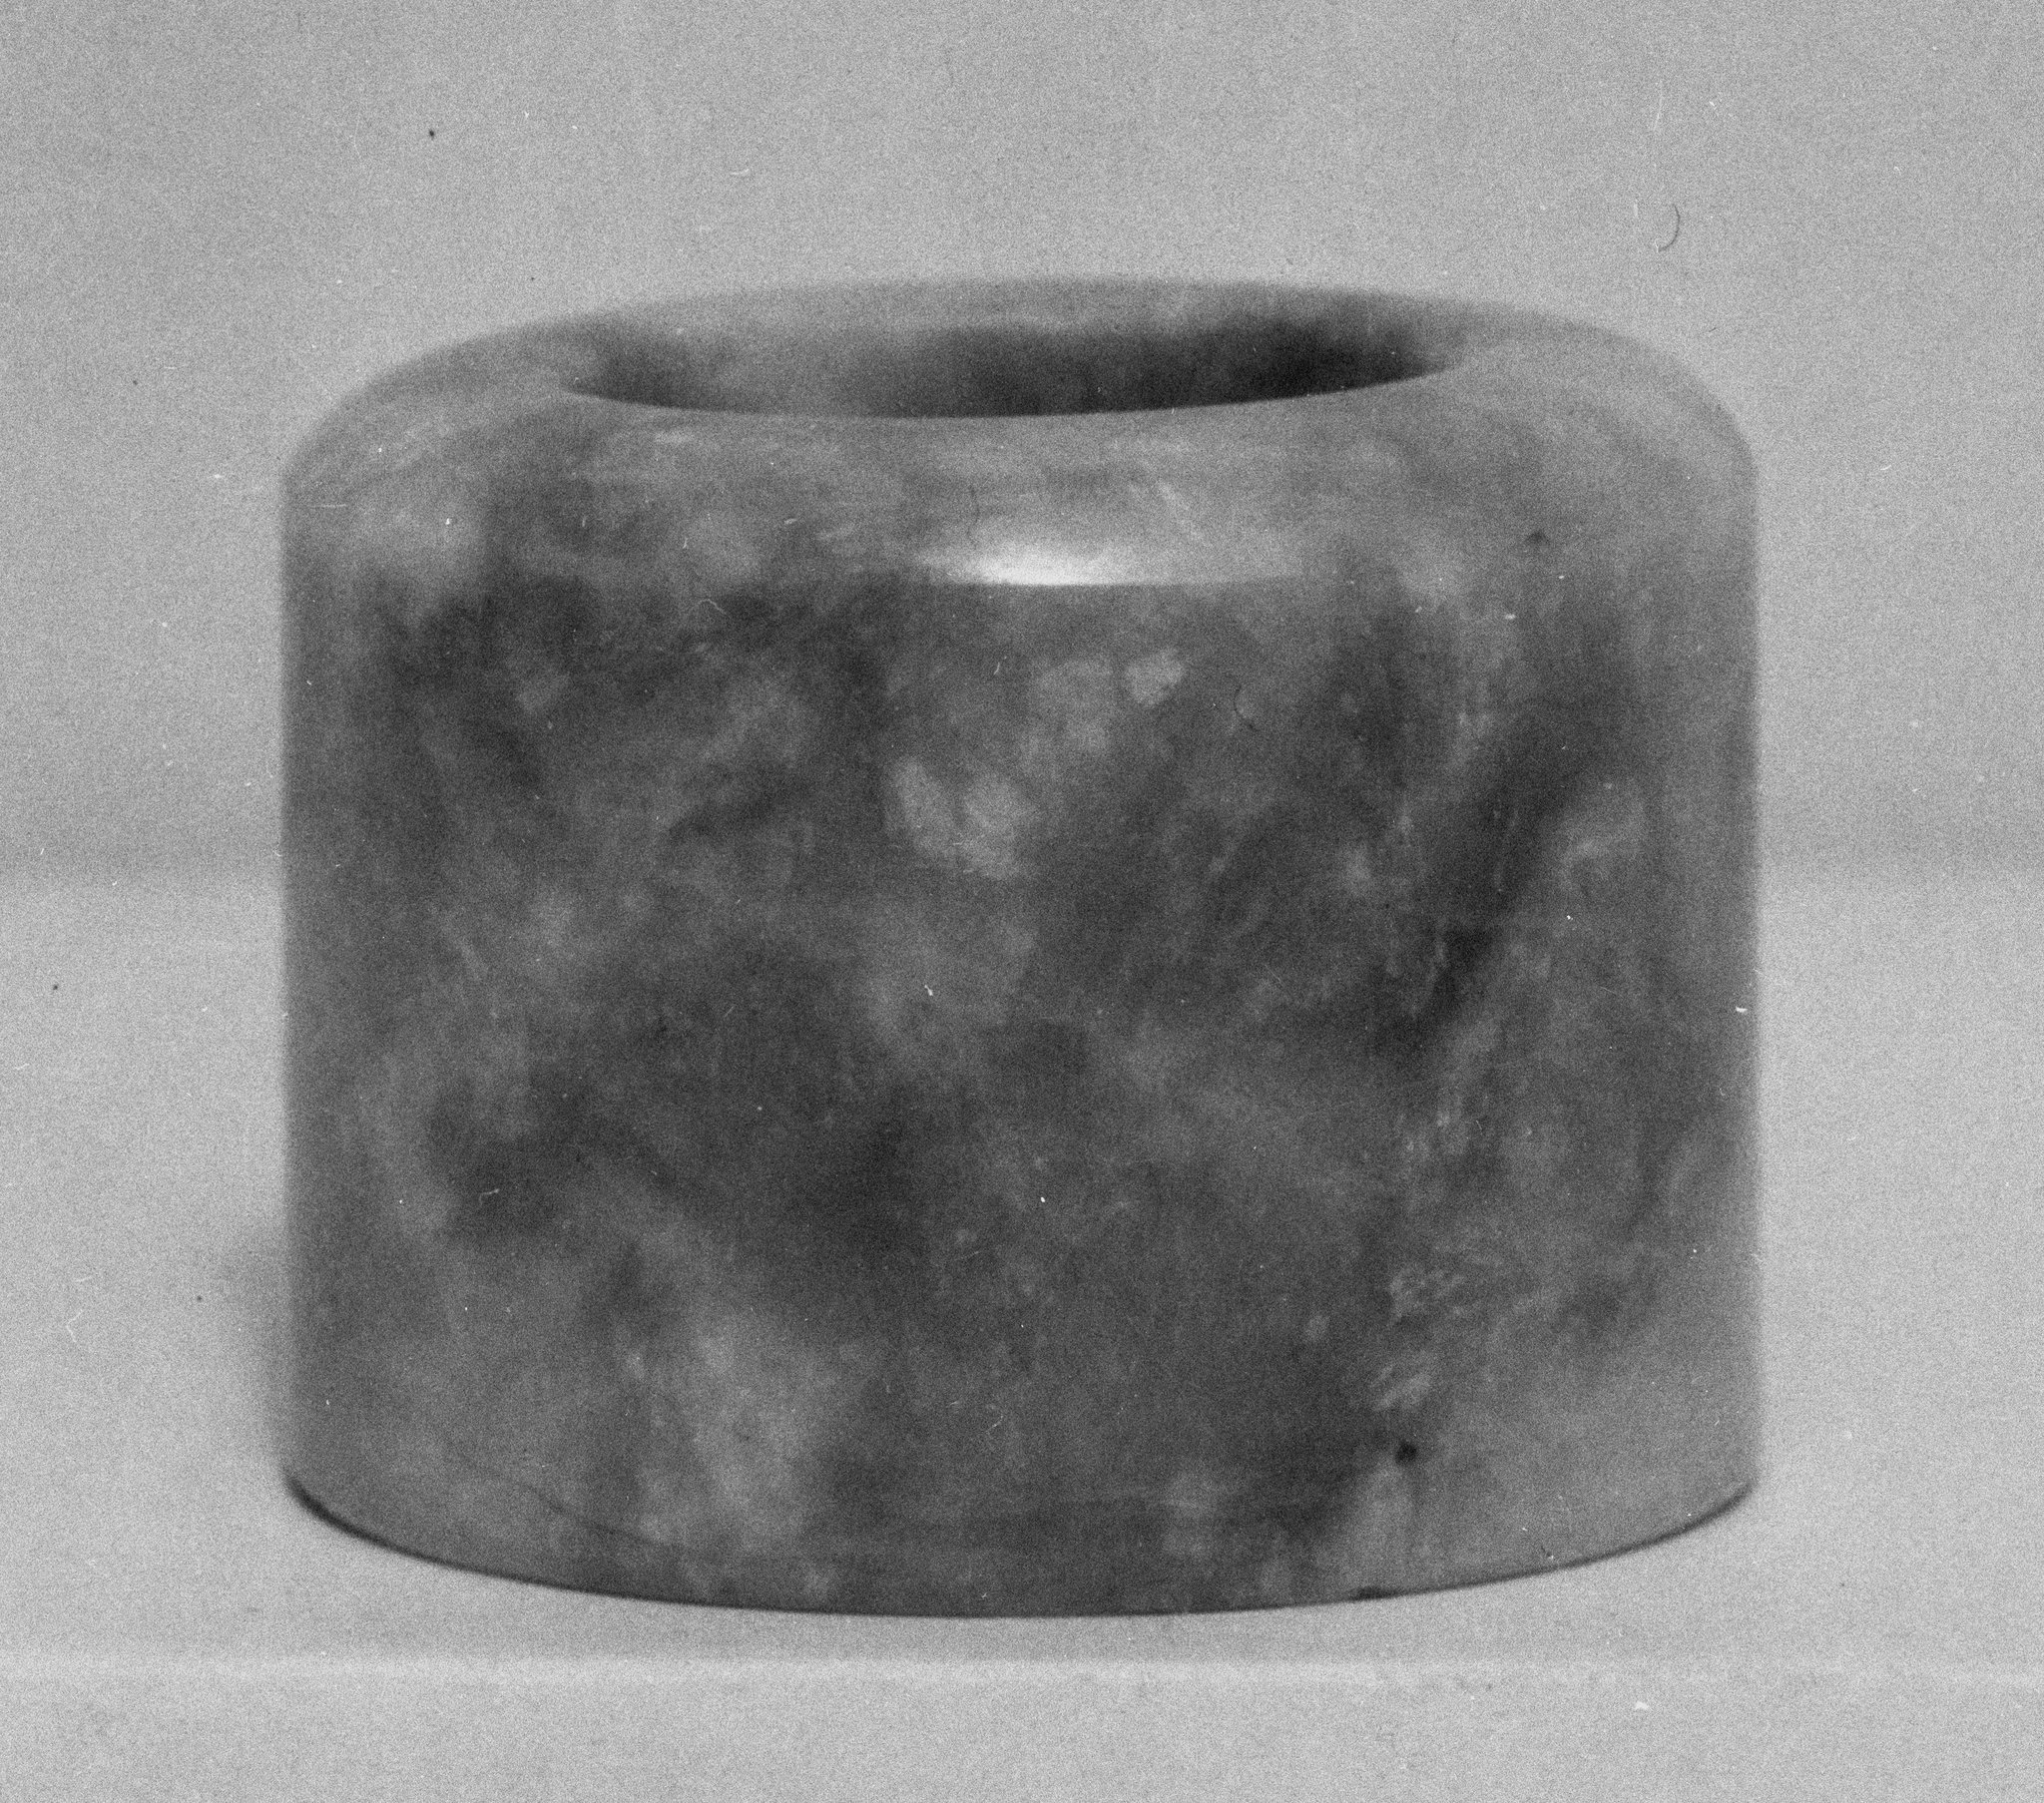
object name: ring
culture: chinese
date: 1736-1795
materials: jade